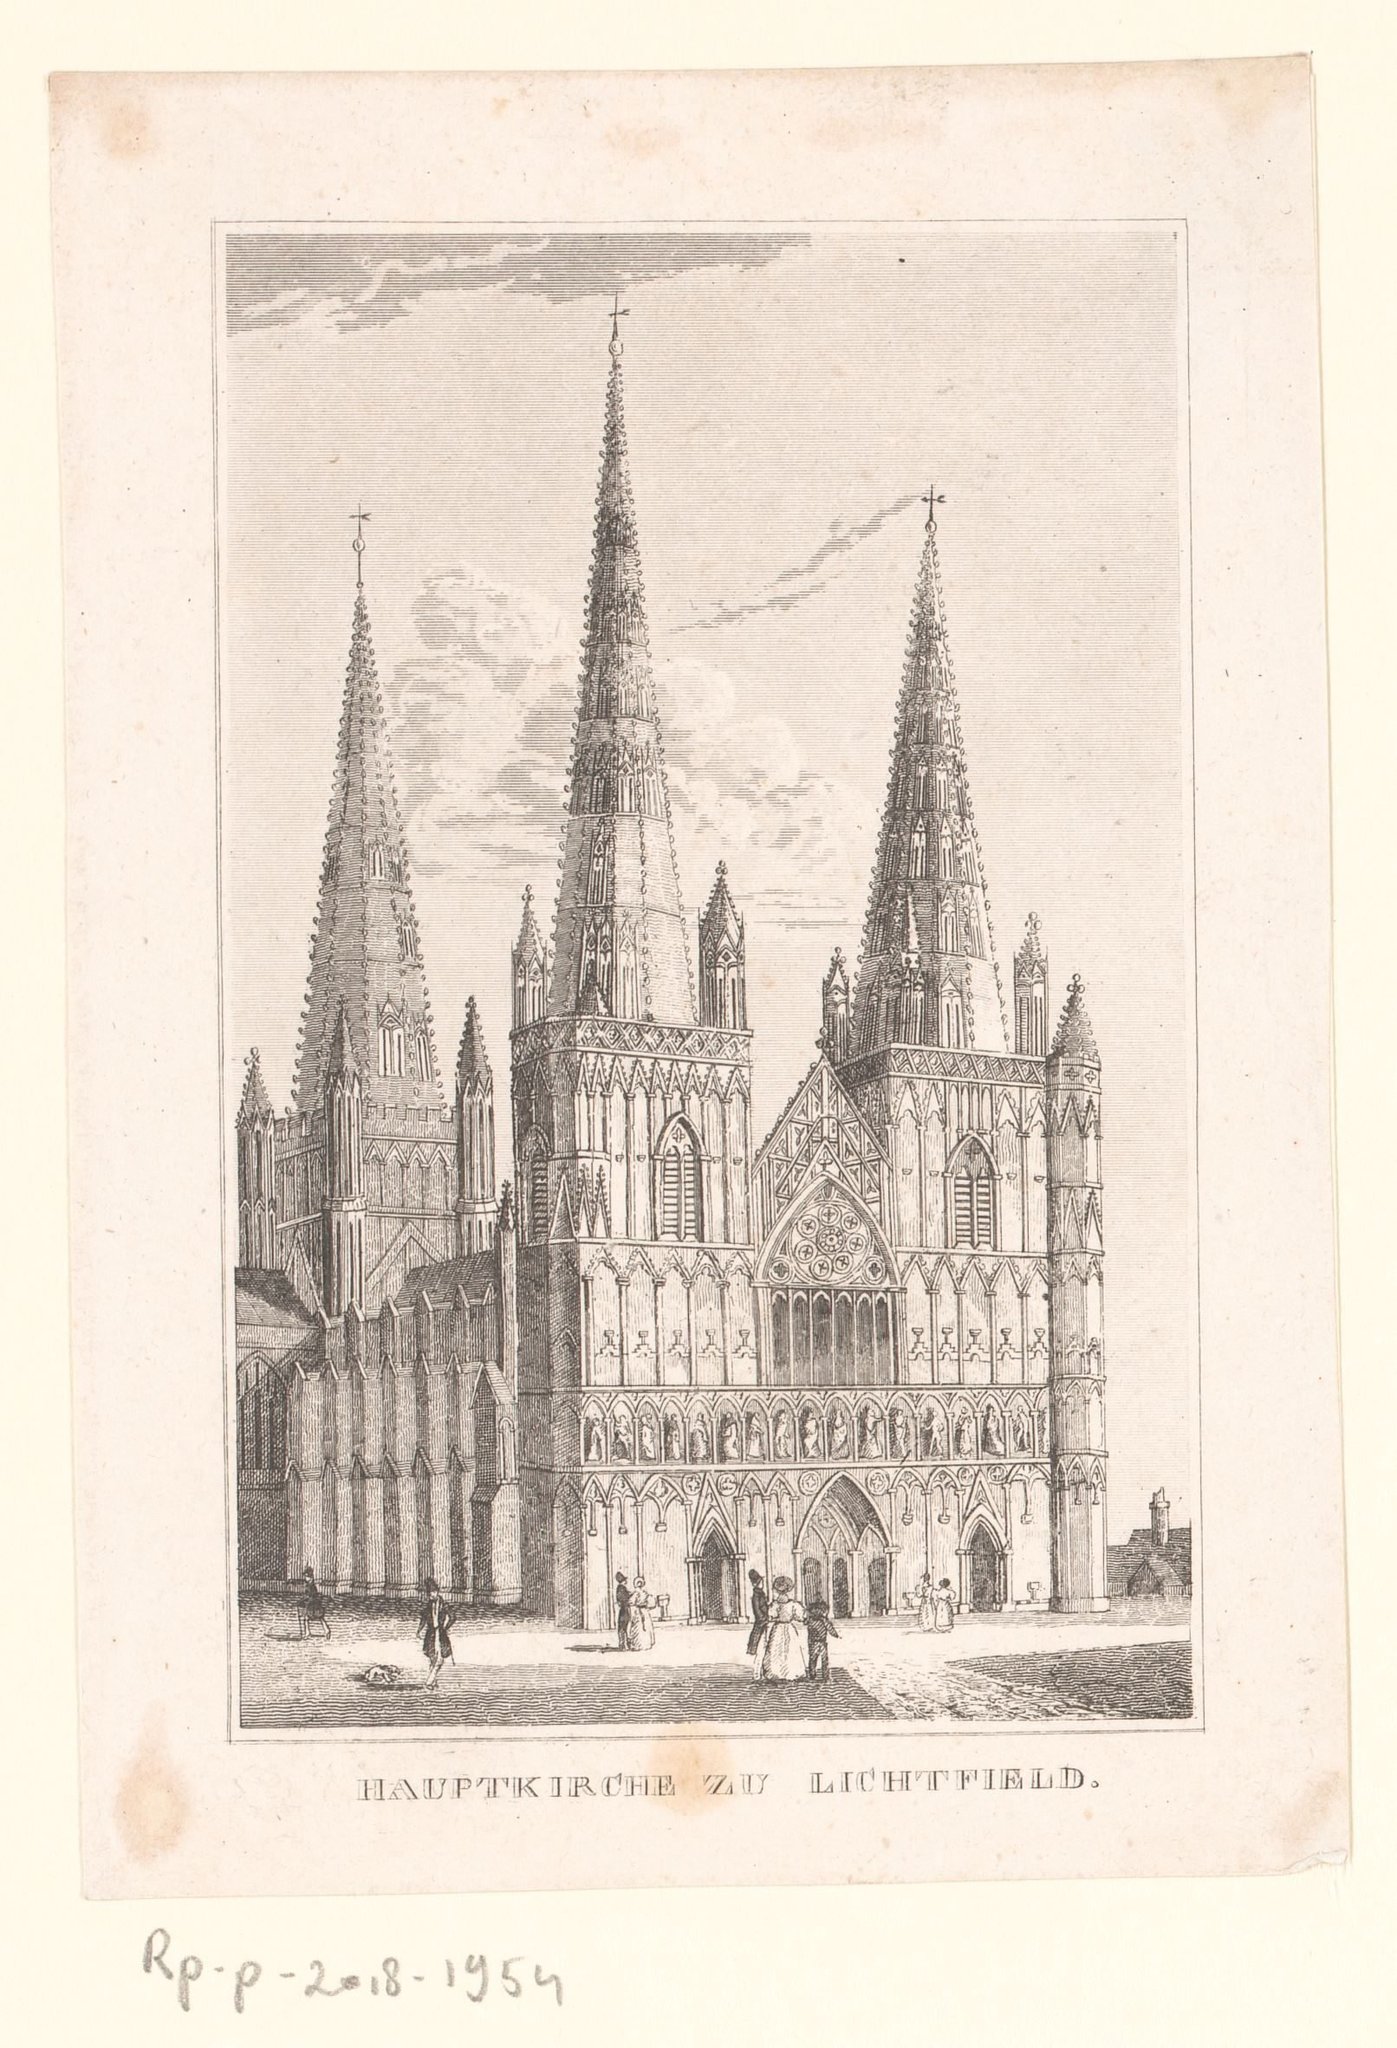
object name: print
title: Gezicht op de Kathedraal van Lichfield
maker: Anonymous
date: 1800-1899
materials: paper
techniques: etching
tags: church (exterior)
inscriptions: collector's mark: Lugt 2228